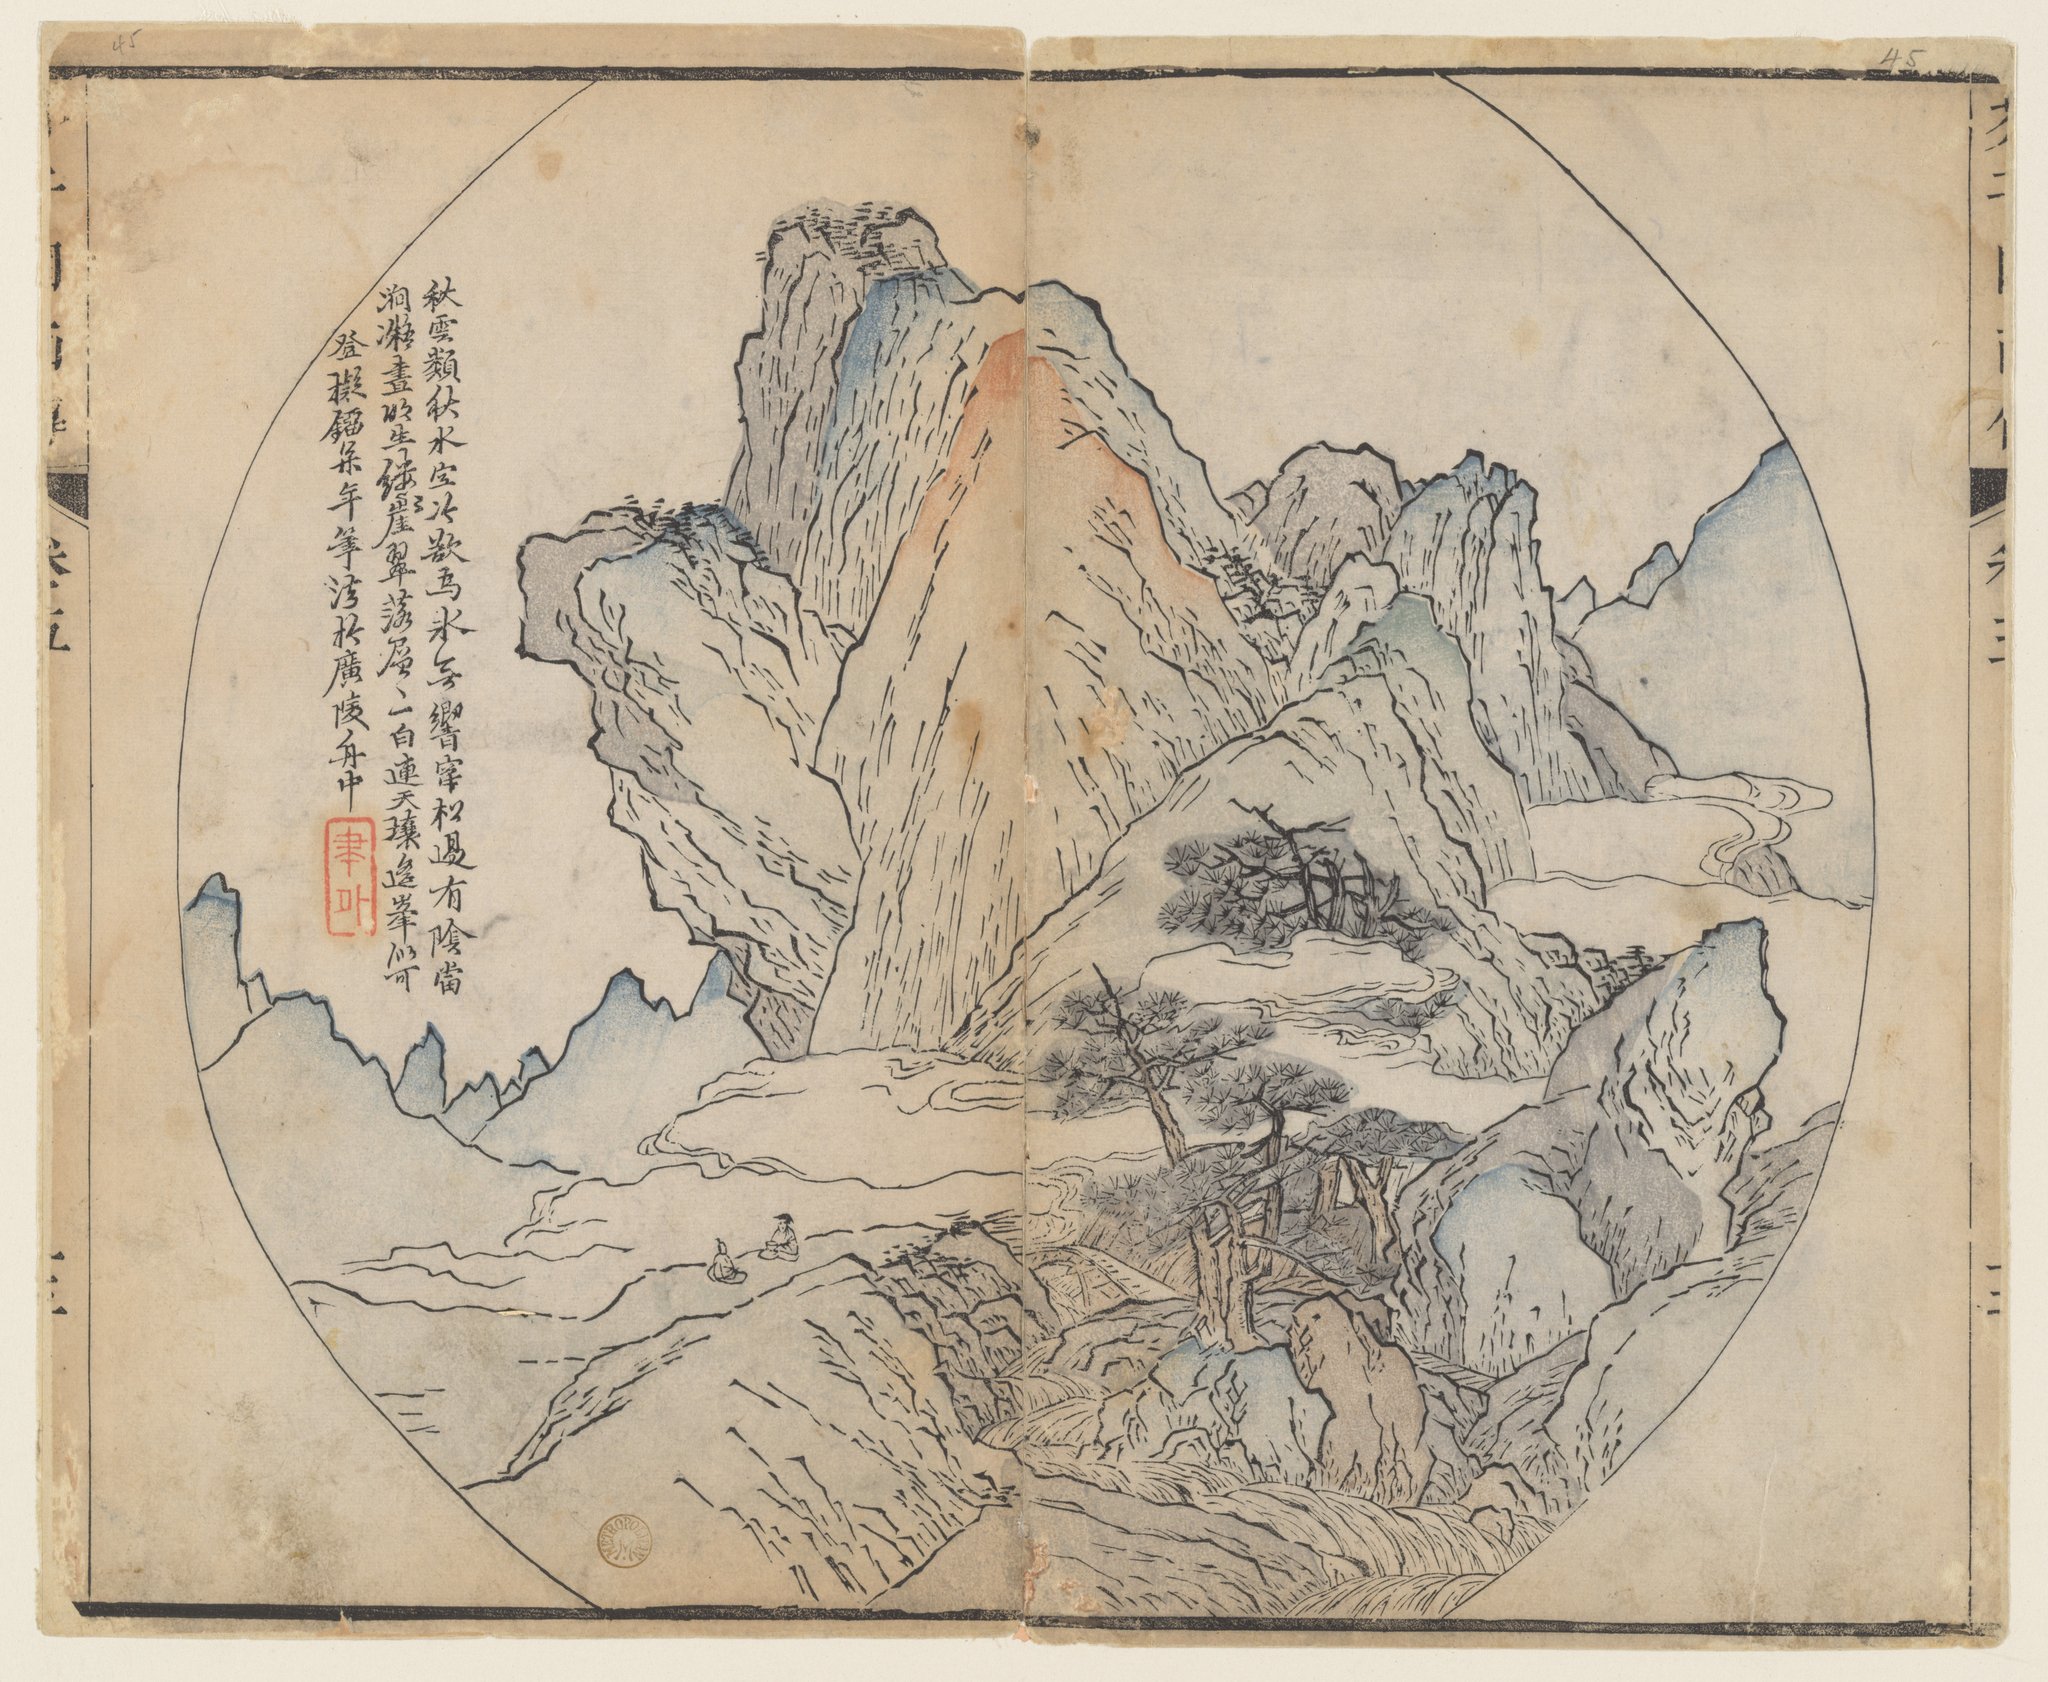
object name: print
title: Page from the Mustard Seed Garden Manual of Painting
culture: chinese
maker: wang gai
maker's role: artist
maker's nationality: chinese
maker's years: 1645-1710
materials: ink, paper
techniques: woodblock print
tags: landscapes